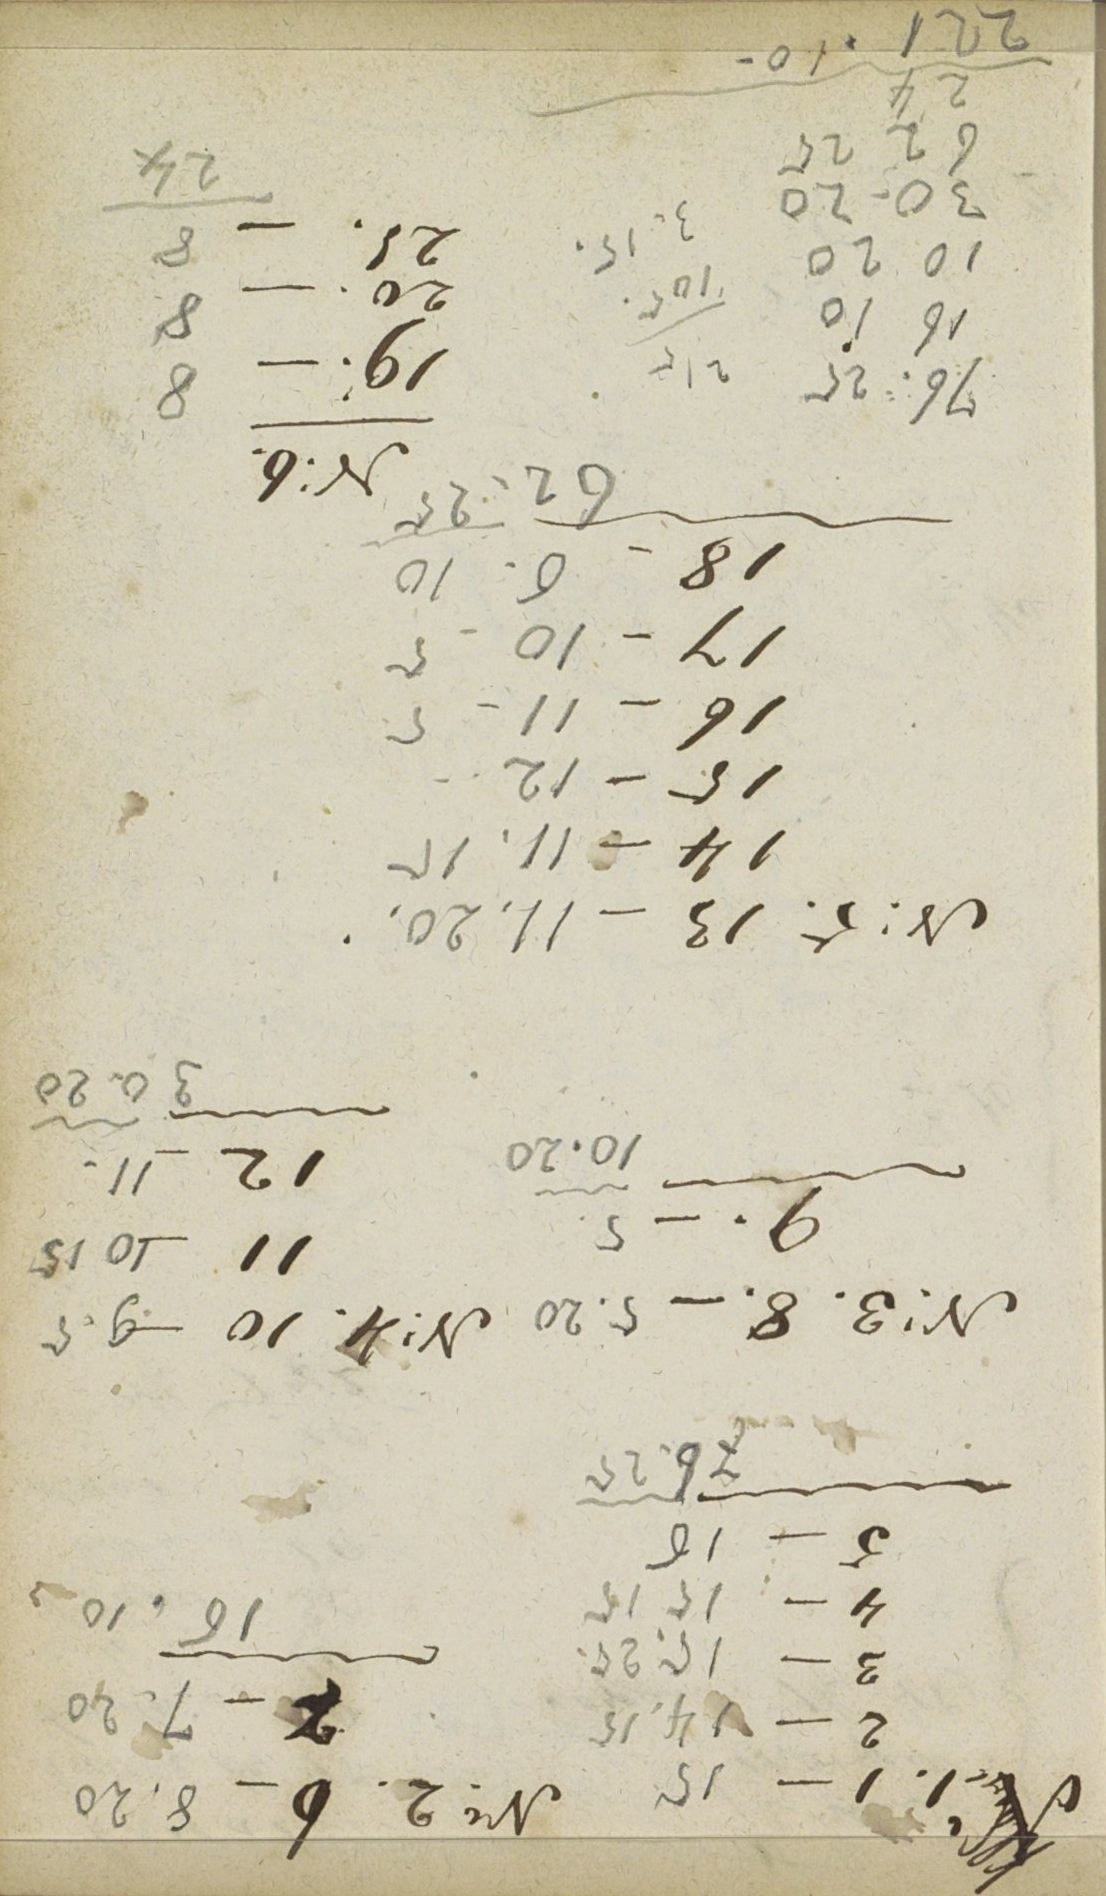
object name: sketchbook leaf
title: Berekeningen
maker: johannes tavenraat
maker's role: draughtsman, painter, print maker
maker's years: 1809-1881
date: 1854-1868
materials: ink, paper, pencil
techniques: pen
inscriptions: annotation: ‘[...]’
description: Blad 81 verso uit een schetsboek met 88 bladen.